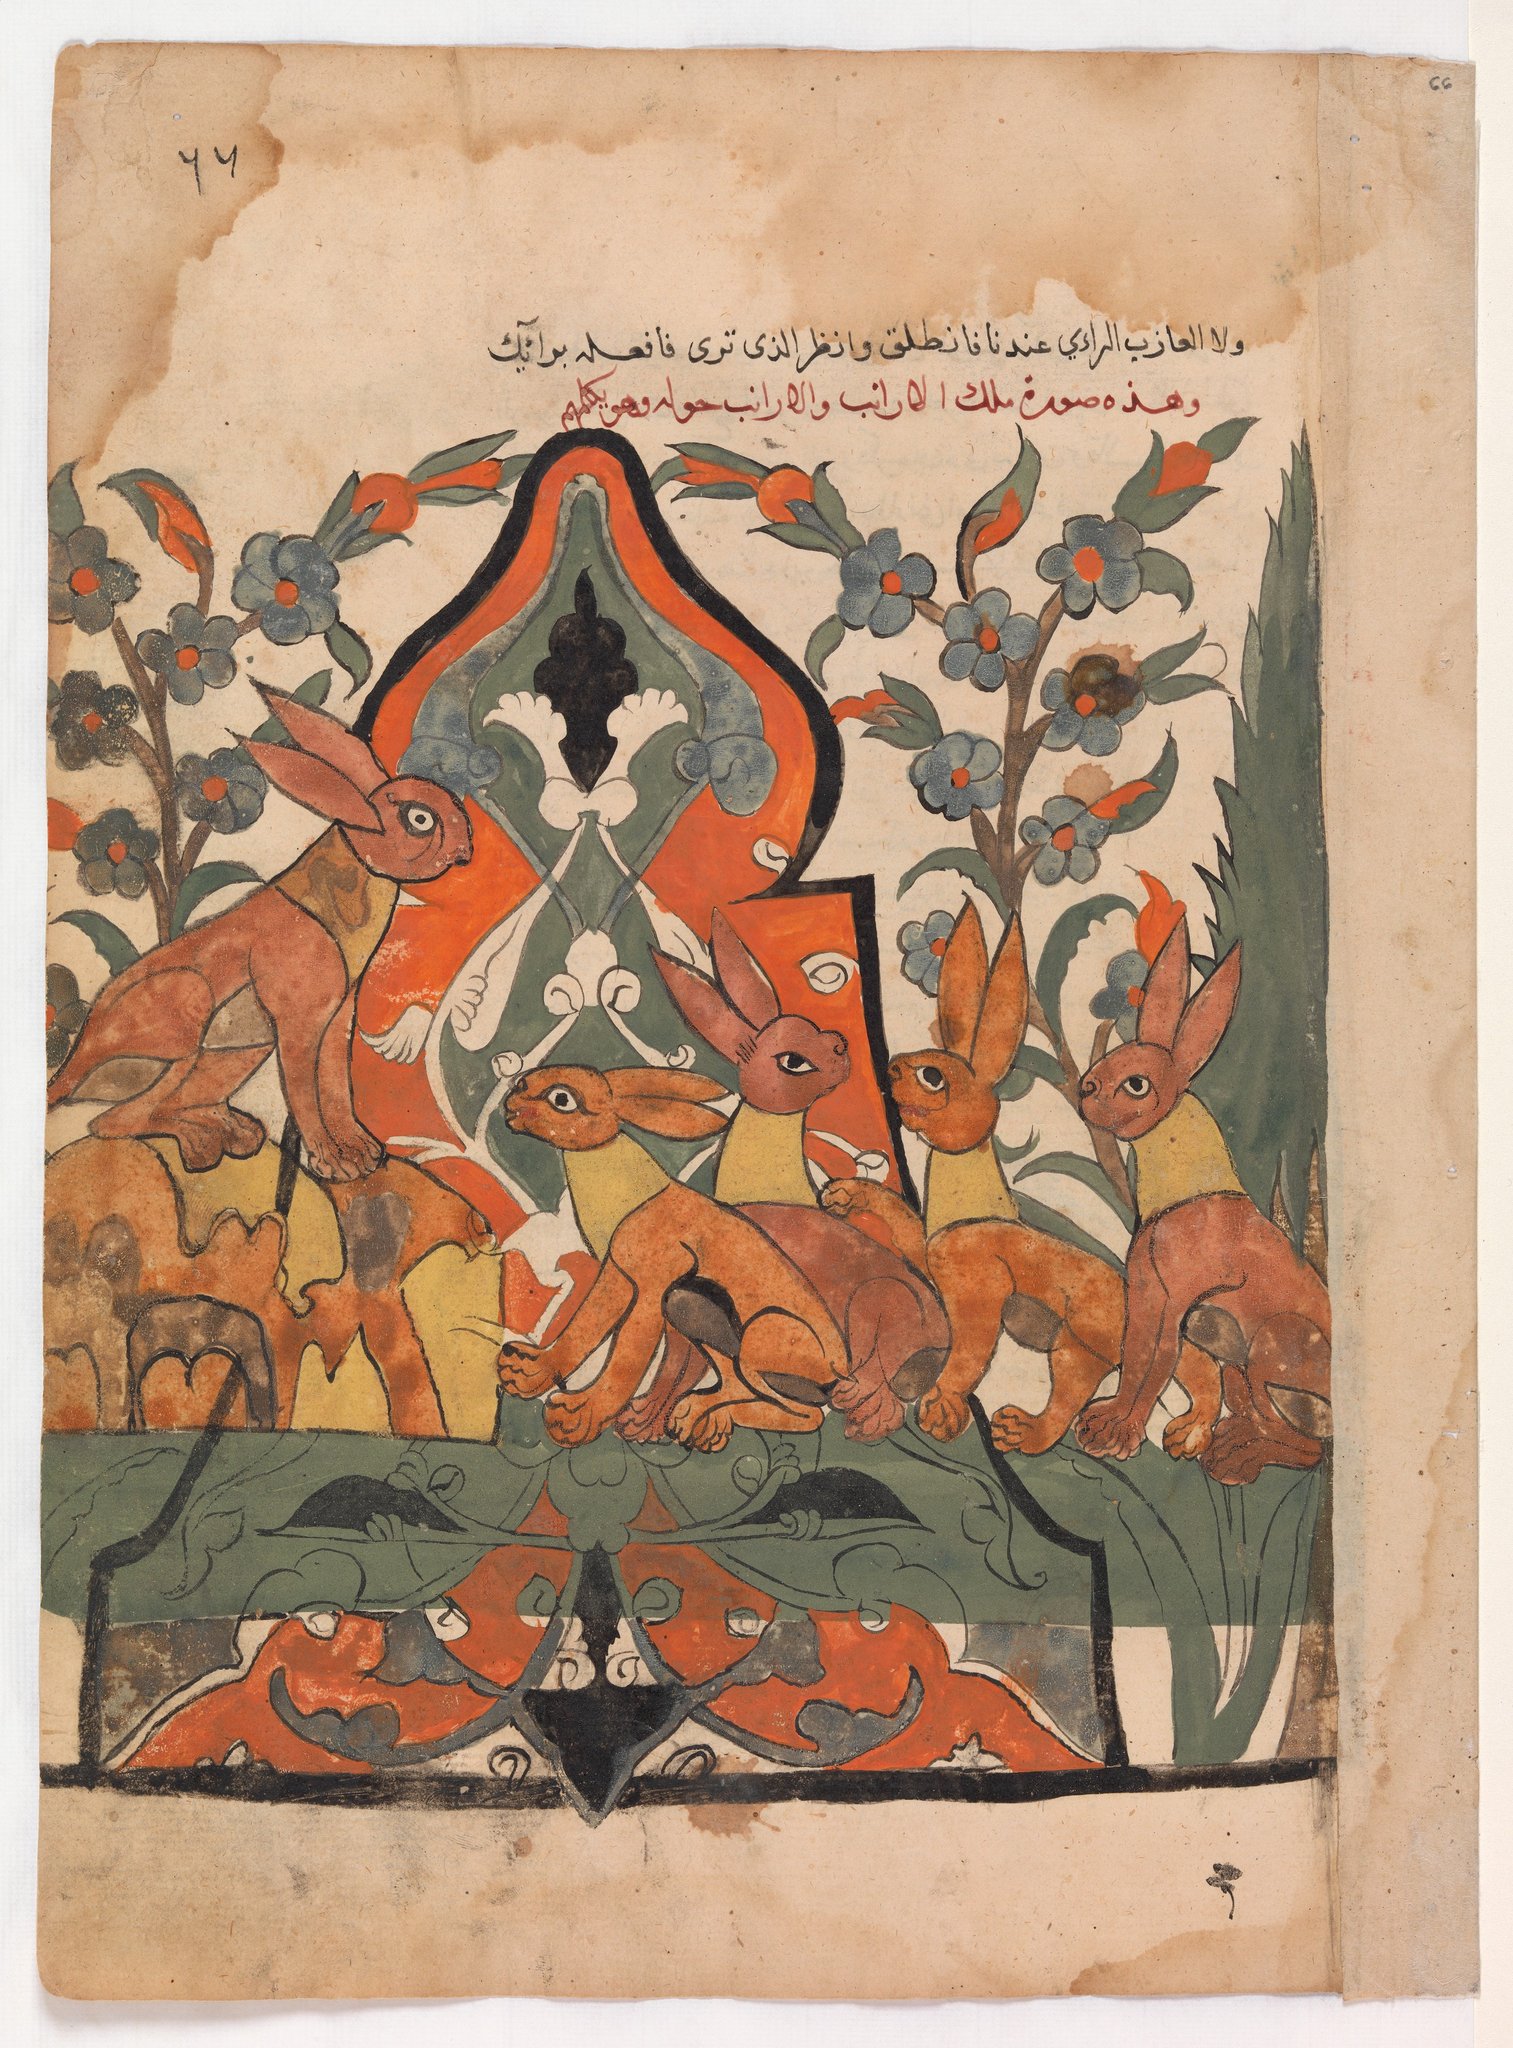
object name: folio from an illustrated manuscript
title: "The King of the Hares in Counsel with his Subjects", Folio from a Kalila wa Dimna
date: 1526-1550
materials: ink, paper, watercolor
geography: india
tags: rabbits,flowers